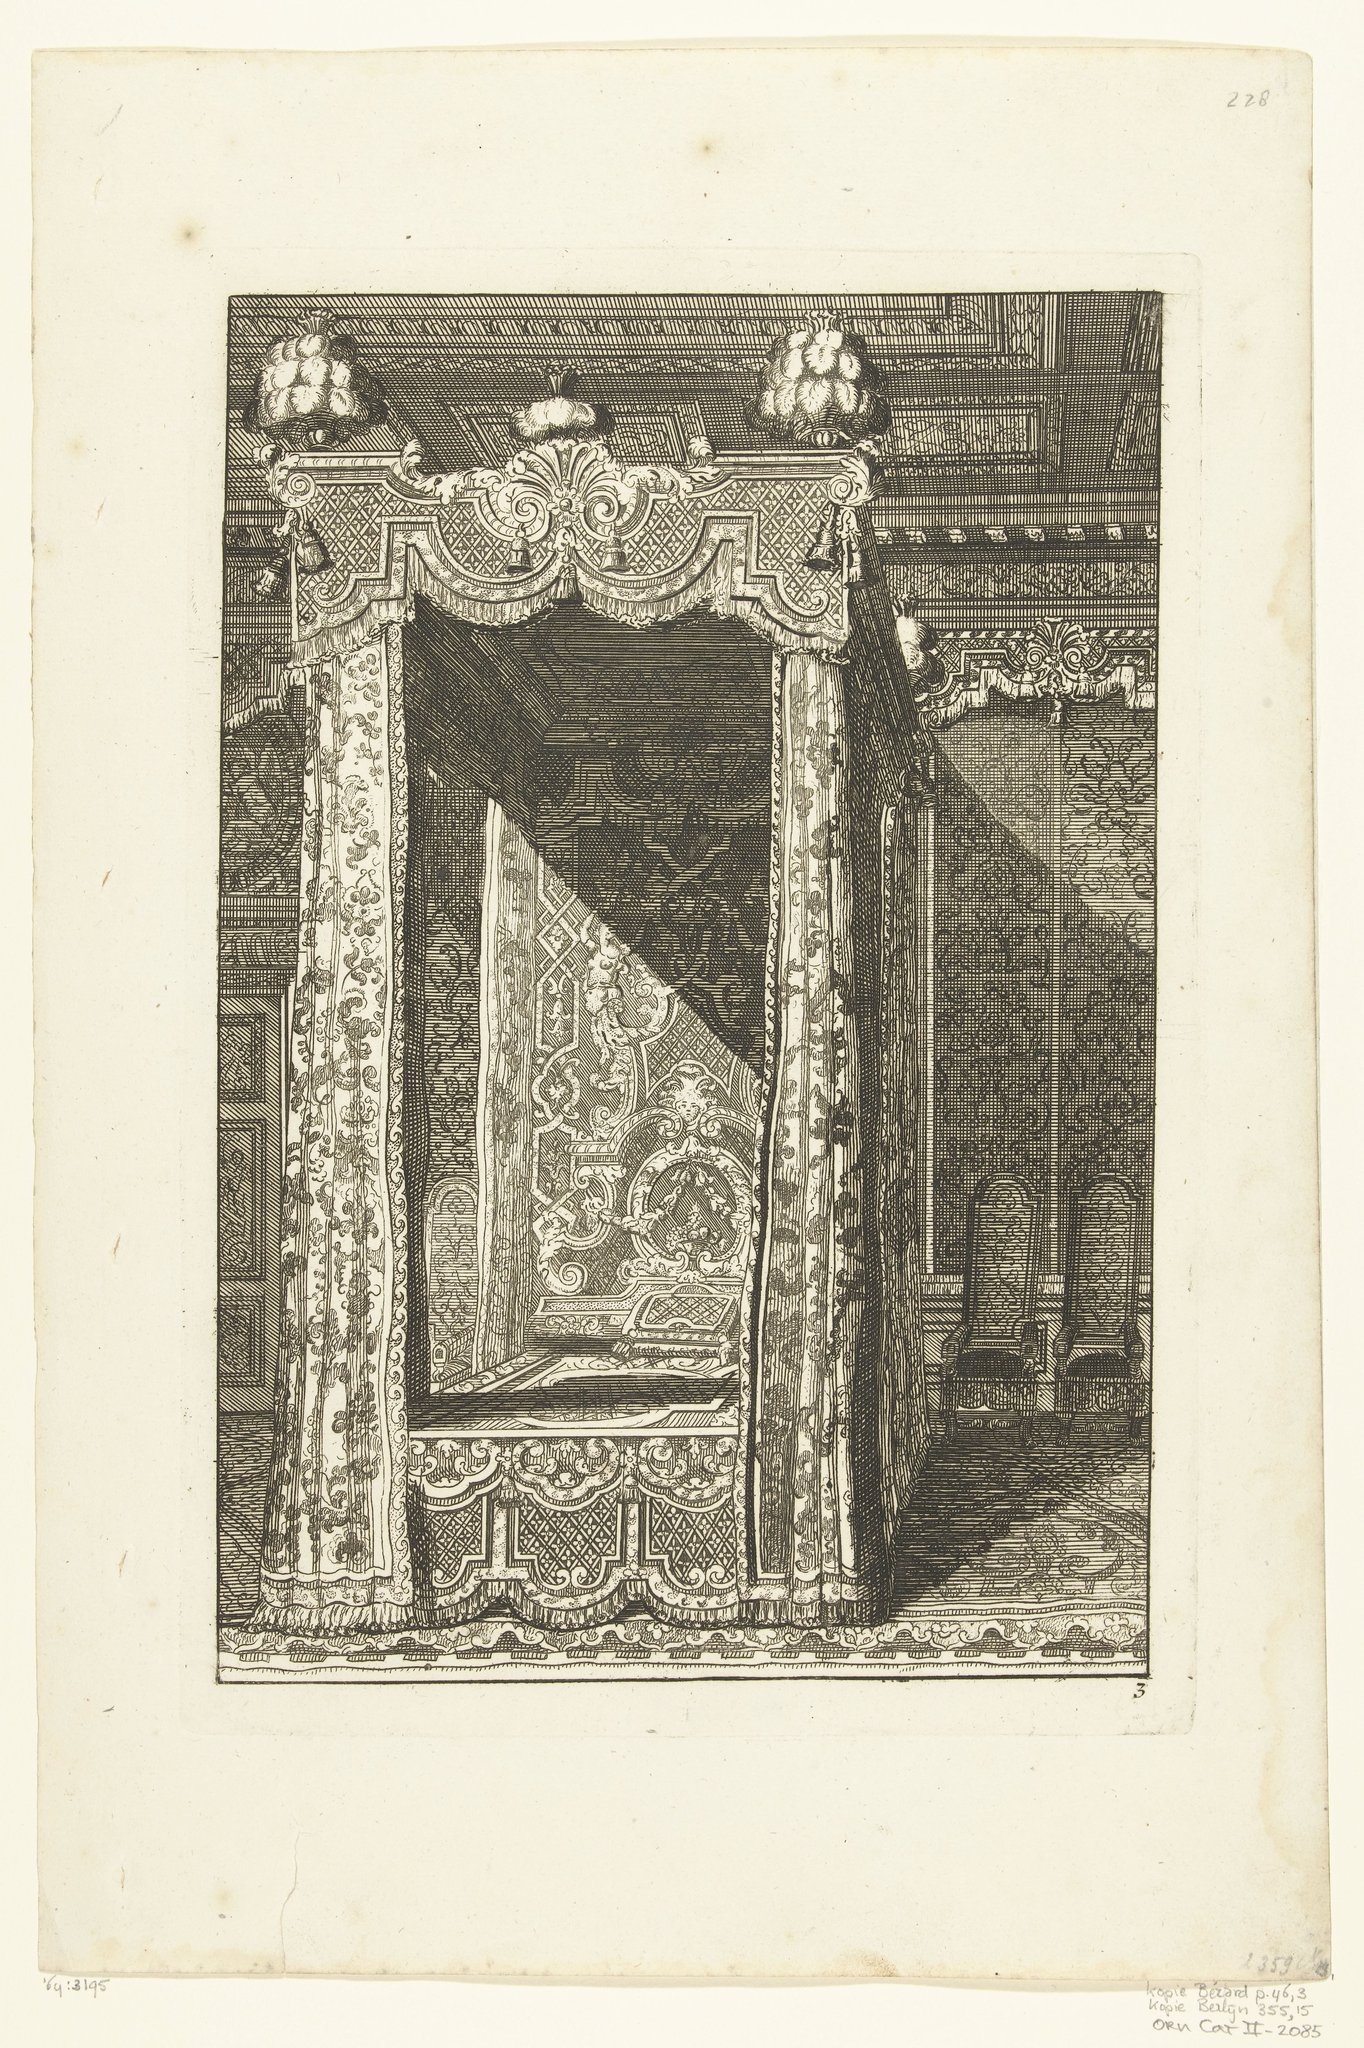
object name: ornament print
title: Hemelbed met gordijnen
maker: Anonymous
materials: paper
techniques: etching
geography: netherlands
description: Rechts staan twee stoelen tegen een muur die bekleed is met stof. Tegenzijdige kopie naar blad uit de serie Second Liure Dappartements.